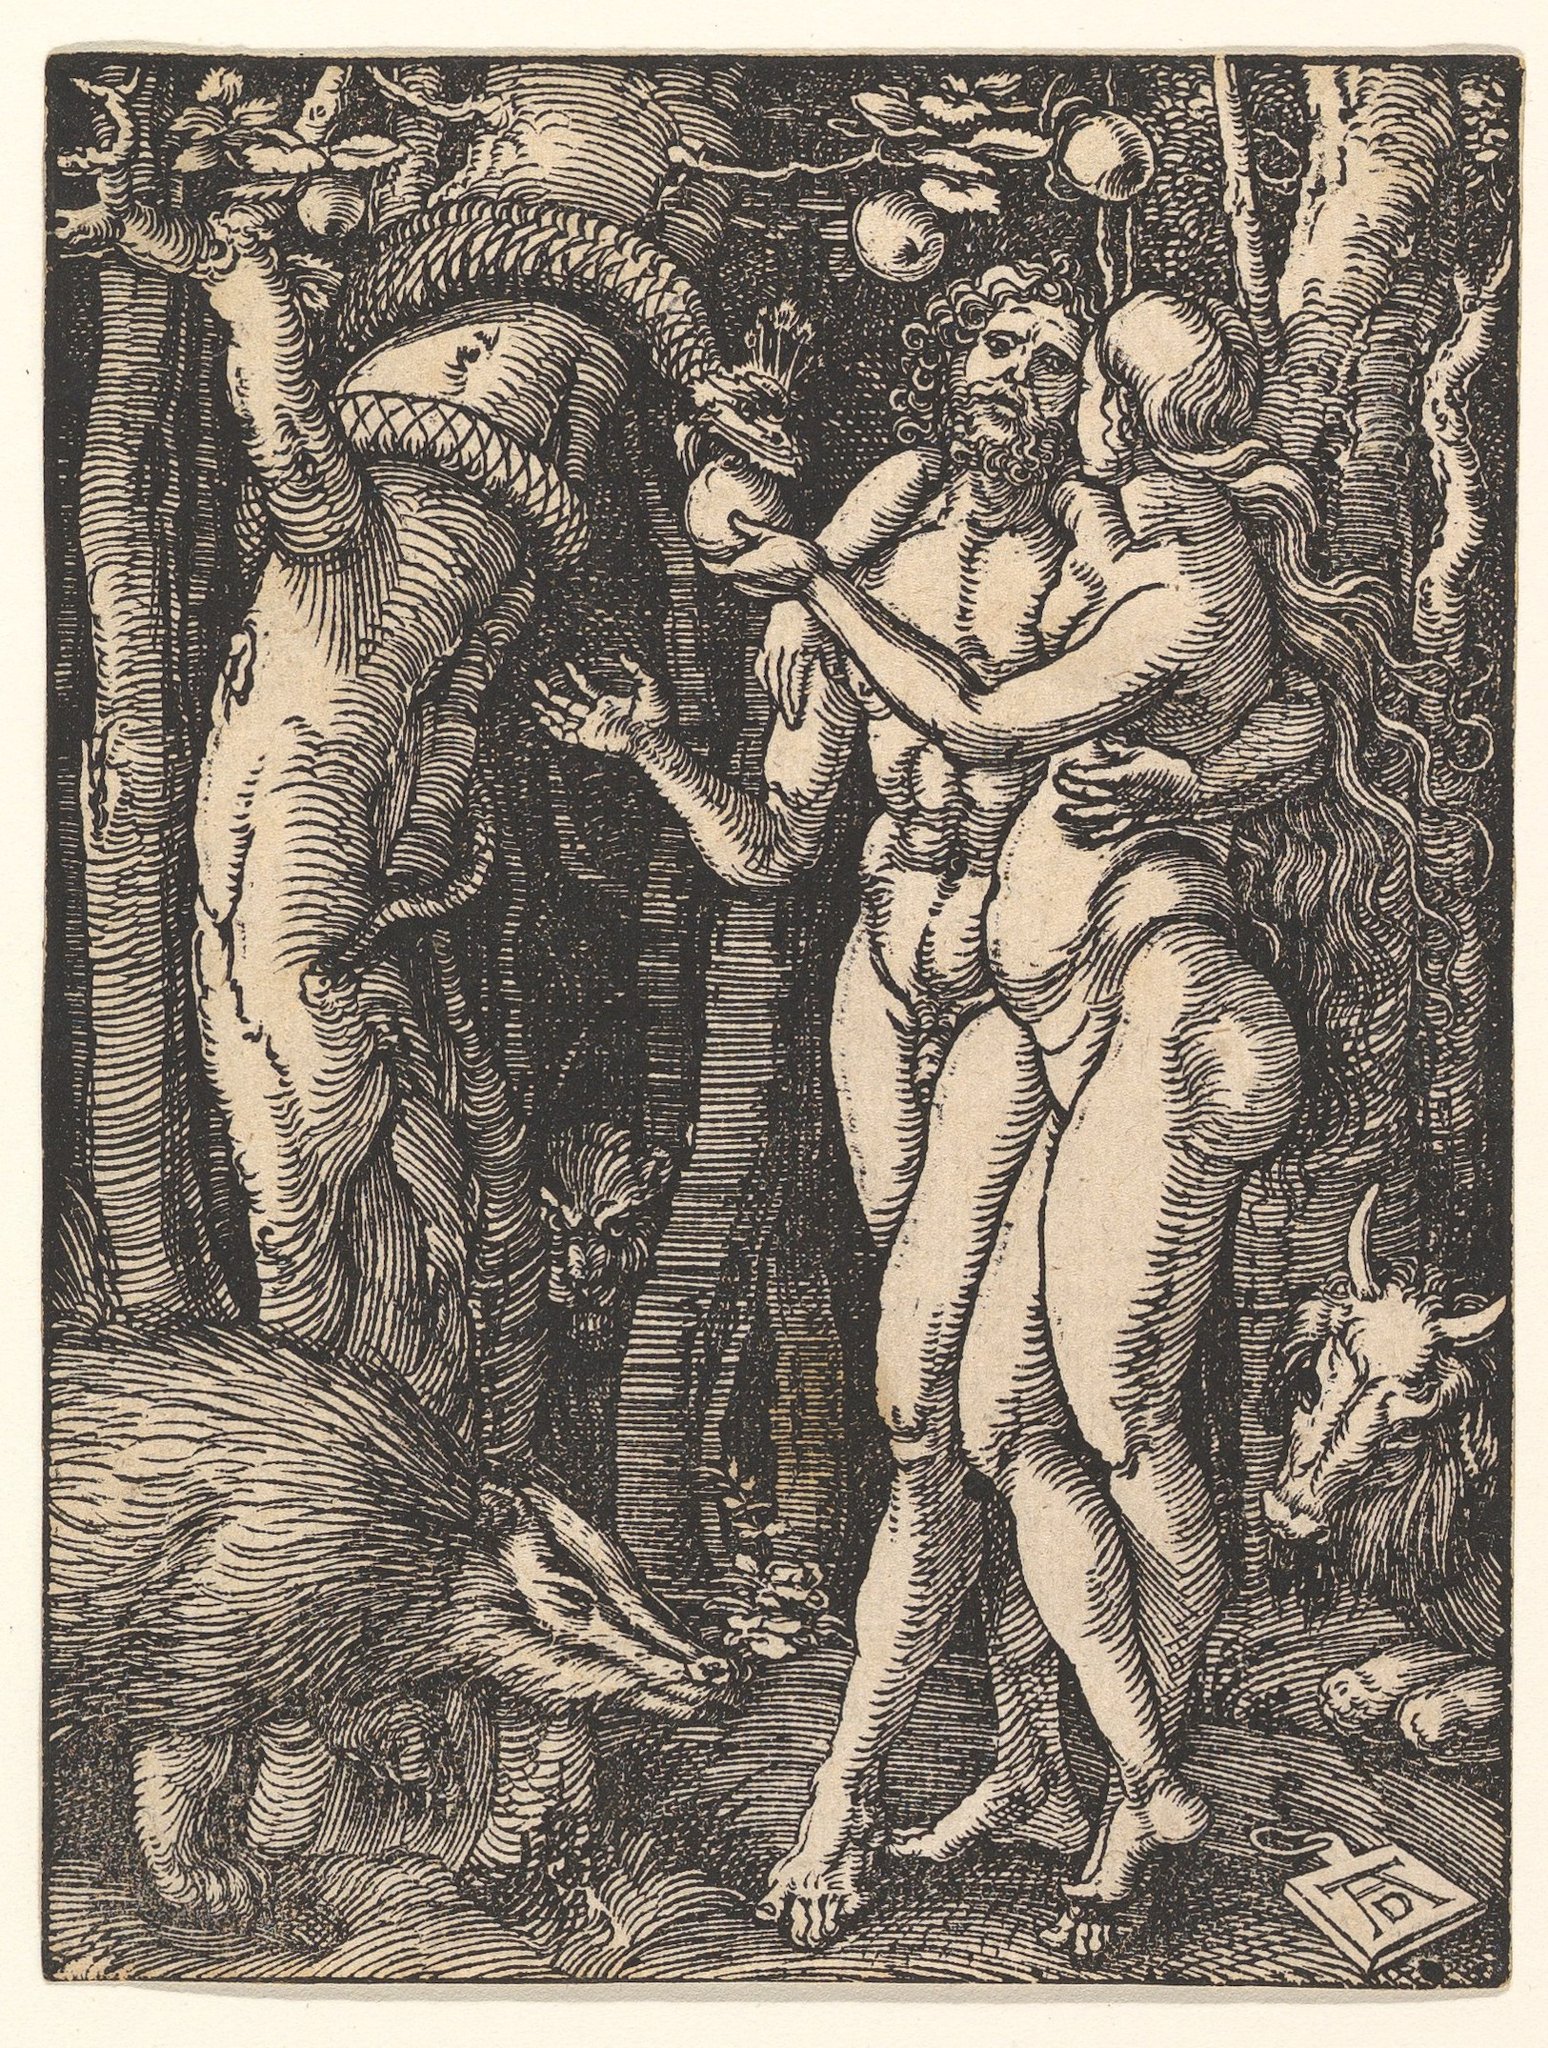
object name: print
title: The Fall of Man, from "The Small Passion"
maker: albrecht dürer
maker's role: artist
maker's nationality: german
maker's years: 1471-1528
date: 1510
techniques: woodcut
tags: boars,goats,serpents,adam,eve